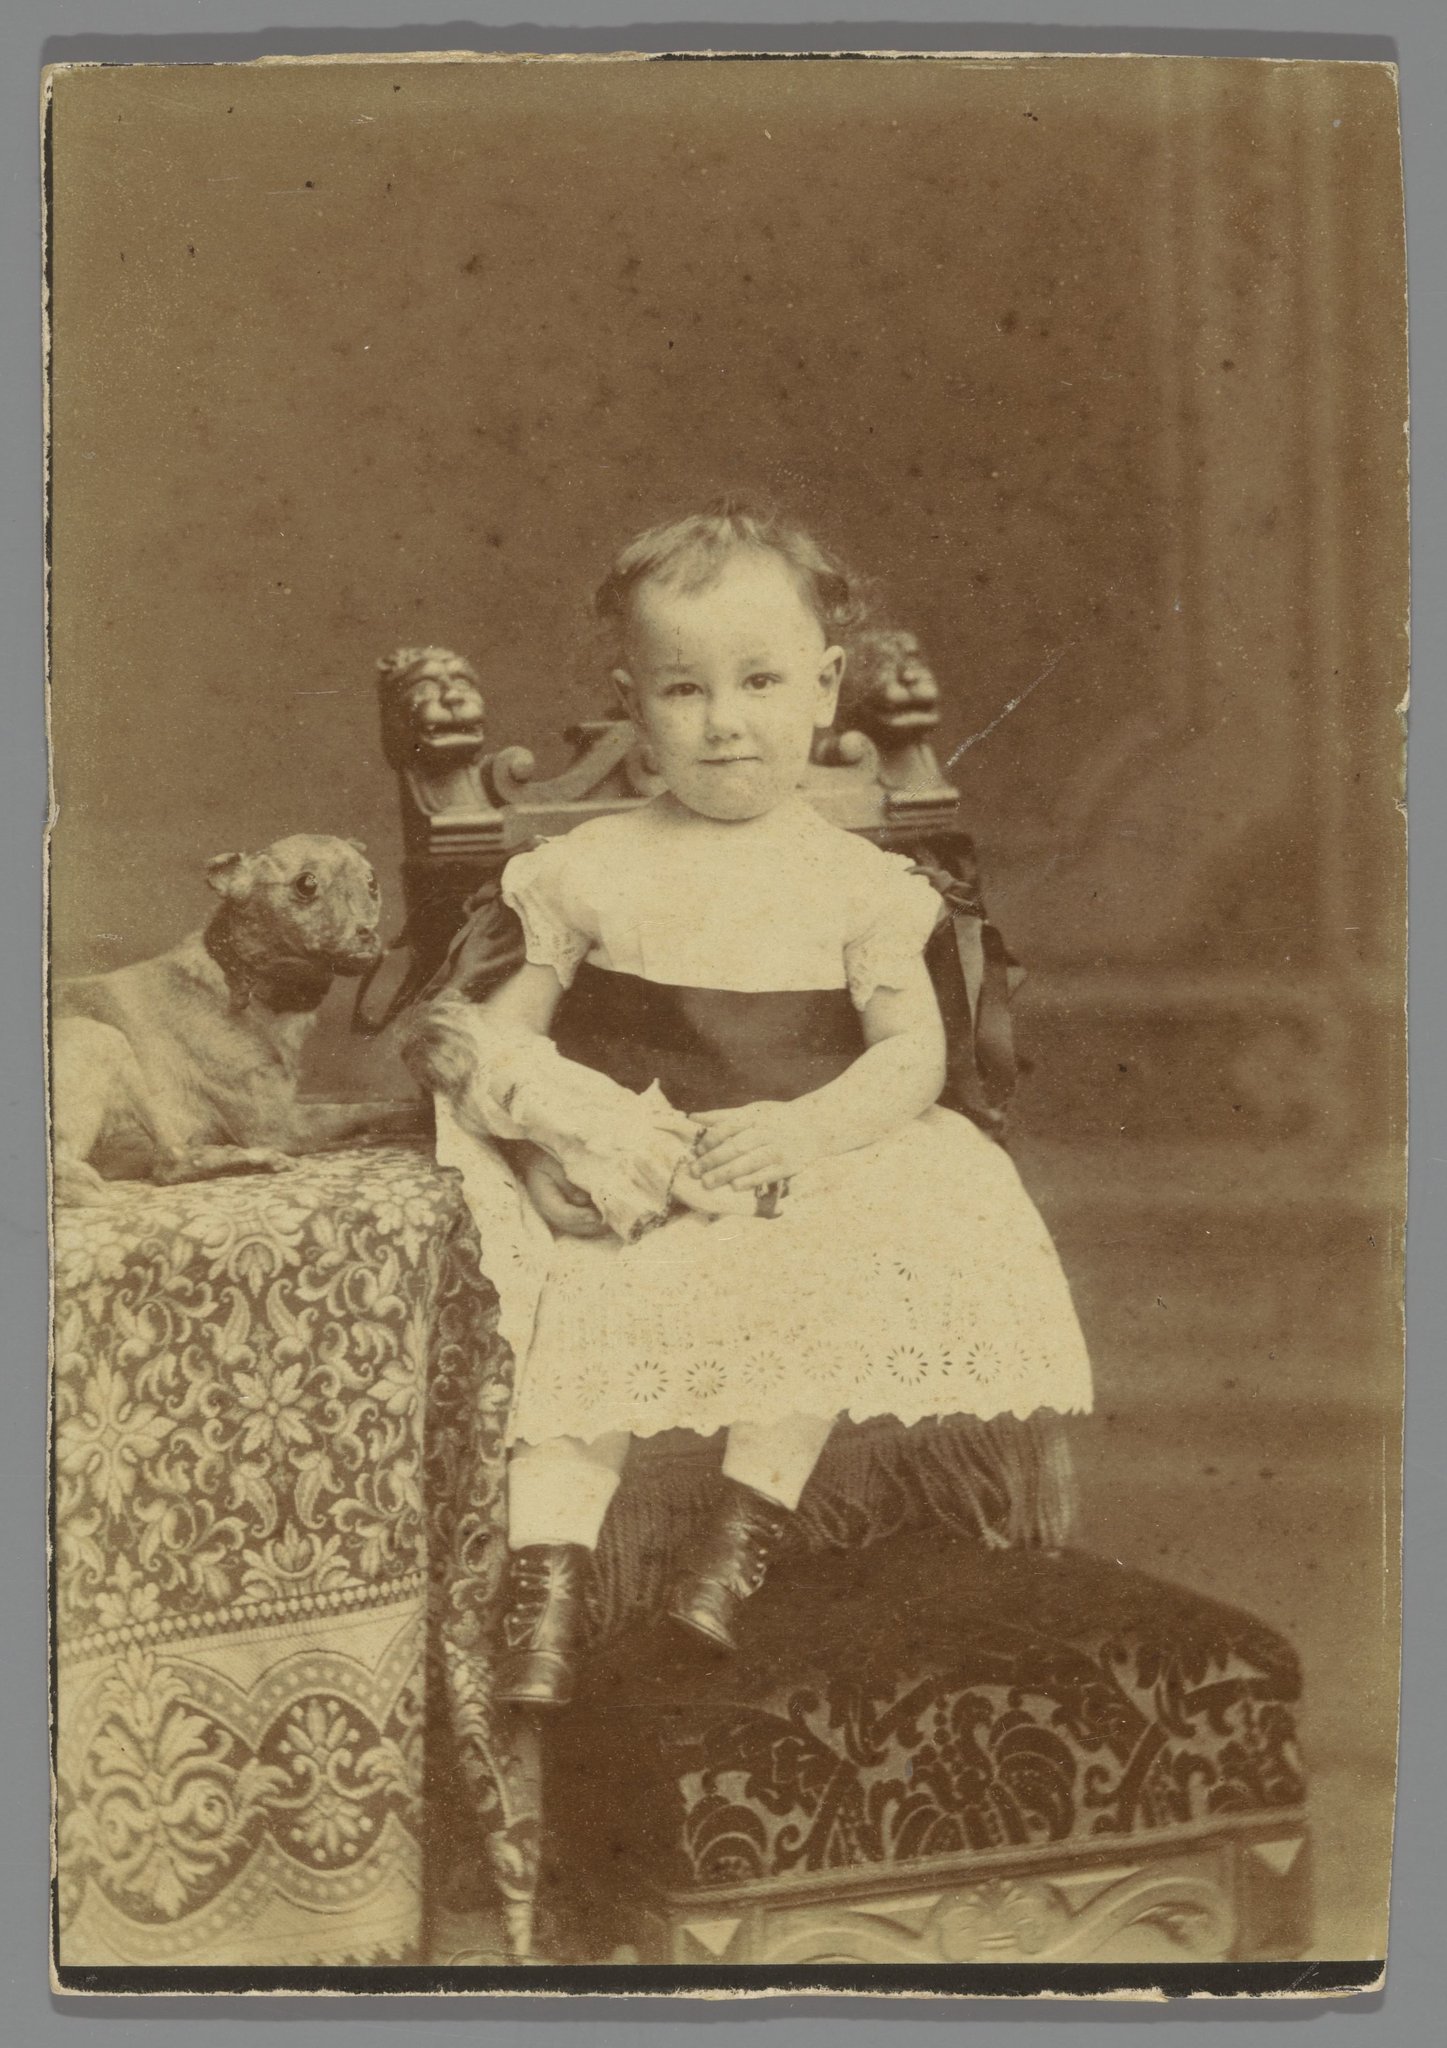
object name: photograph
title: Portret van Kitty van Braam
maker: Anonymous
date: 1880-1890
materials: photographic support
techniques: albumen print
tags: historical persons - bb - woman, (playing with) dolls, toddler (female)